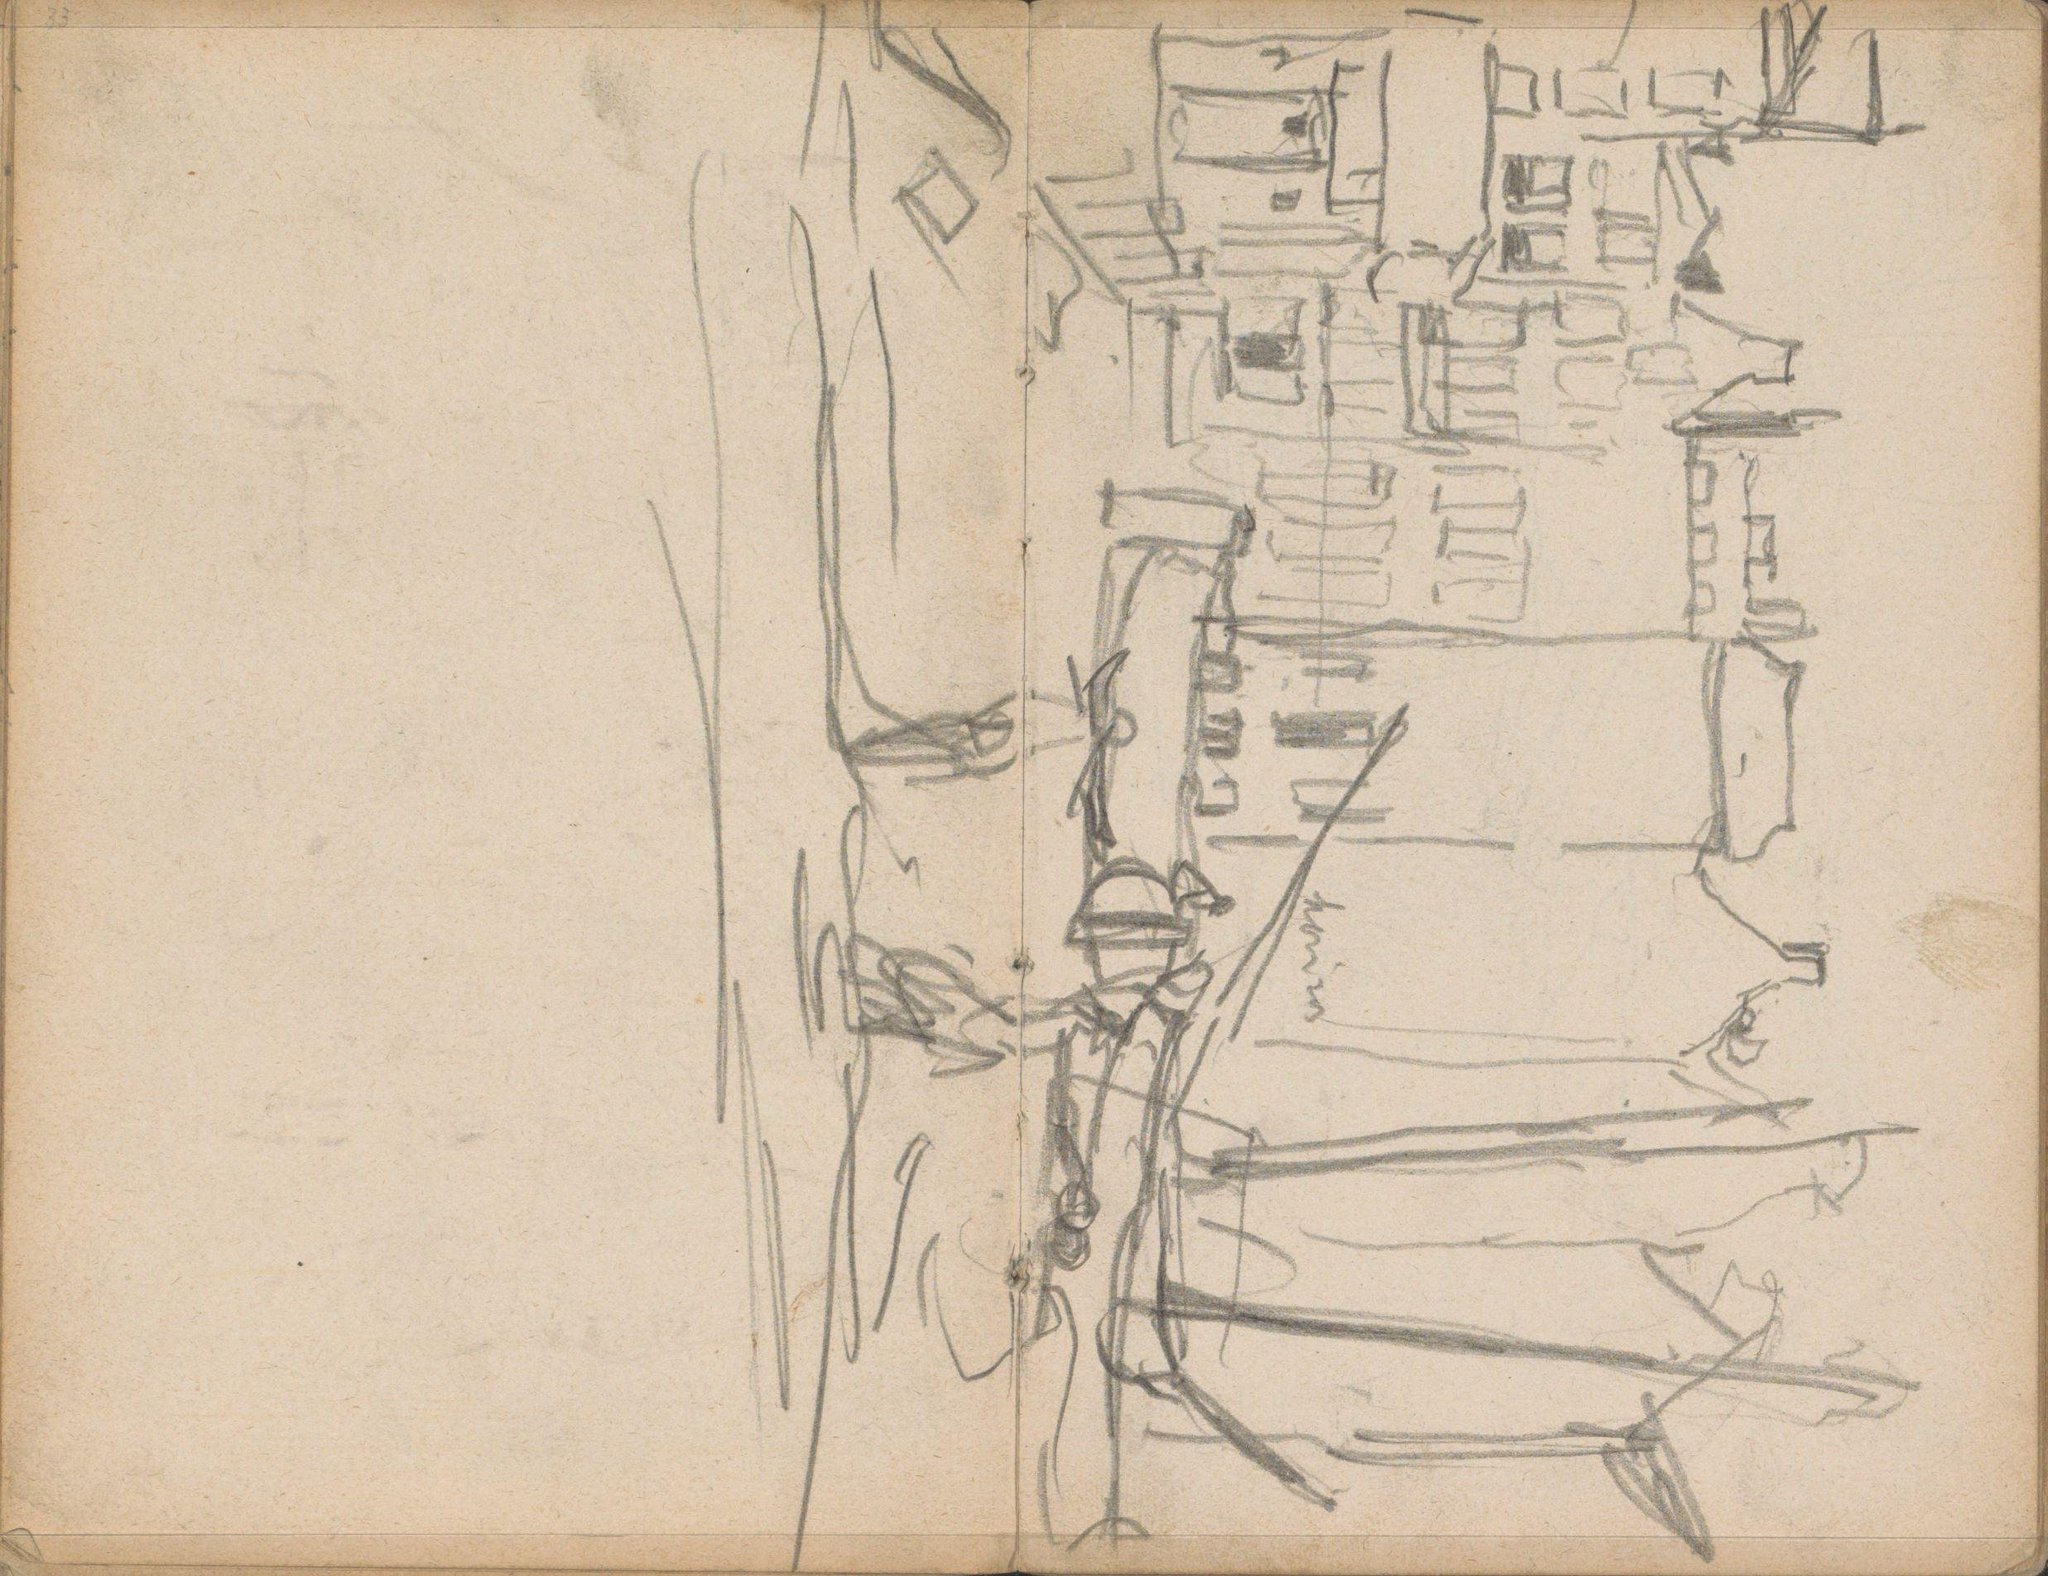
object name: sketchbook leaf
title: Gezicht op het Damrak te Amsterdam met de huizen aan de Warmoesstraat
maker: george hendrik breitner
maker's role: draughtsman, painter, print maker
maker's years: 1857-1923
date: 1900-1901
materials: paper, pencil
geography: amsterdam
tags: urban housing, ships (in general)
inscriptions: annotation: ‘horizon’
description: Gezicht op het Damrak te Amsterdam met de achterzijde van de huizen aan de Warmoesstraat. In het water boten. Pagina 33 en pagina 34 uit een schetsboek met 46 bladen vervaardigd te Amsterdam.